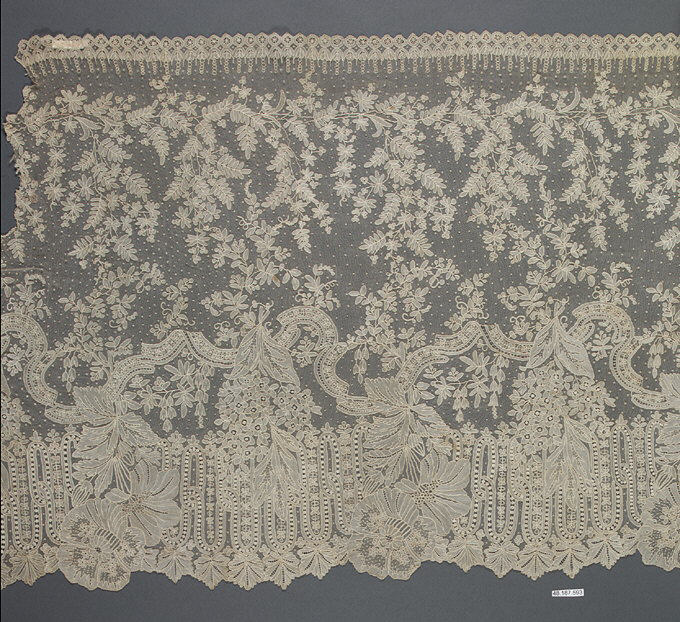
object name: flounce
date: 1851-1900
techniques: lace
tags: flowers